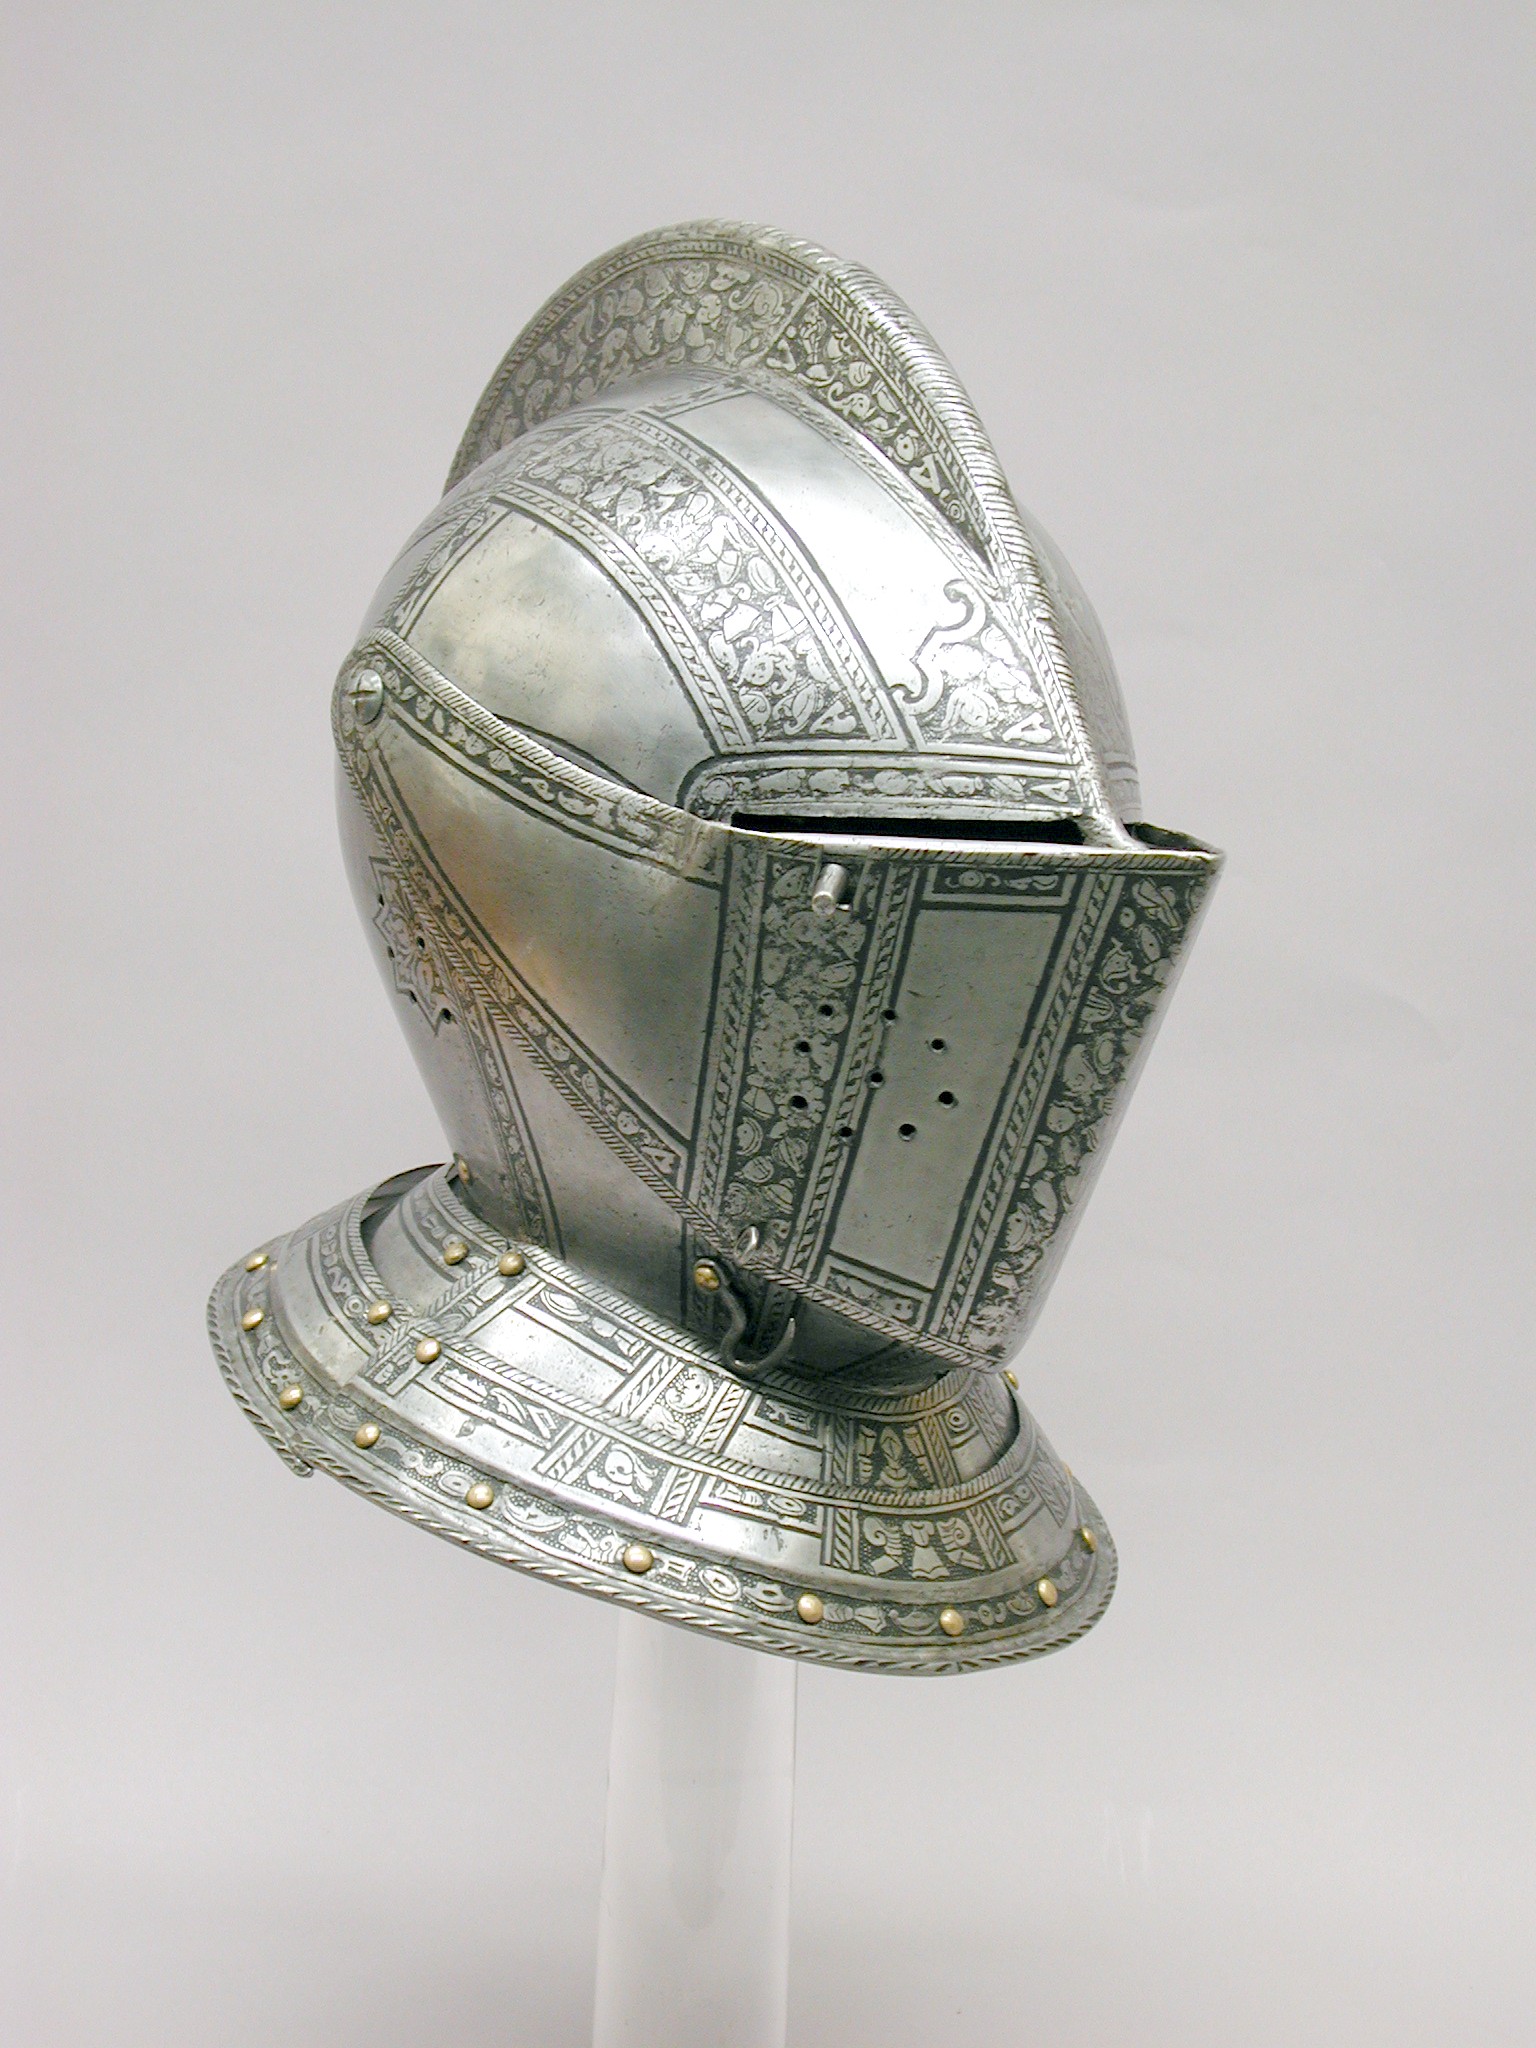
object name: close helmet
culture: italian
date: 1575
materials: steel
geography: italy